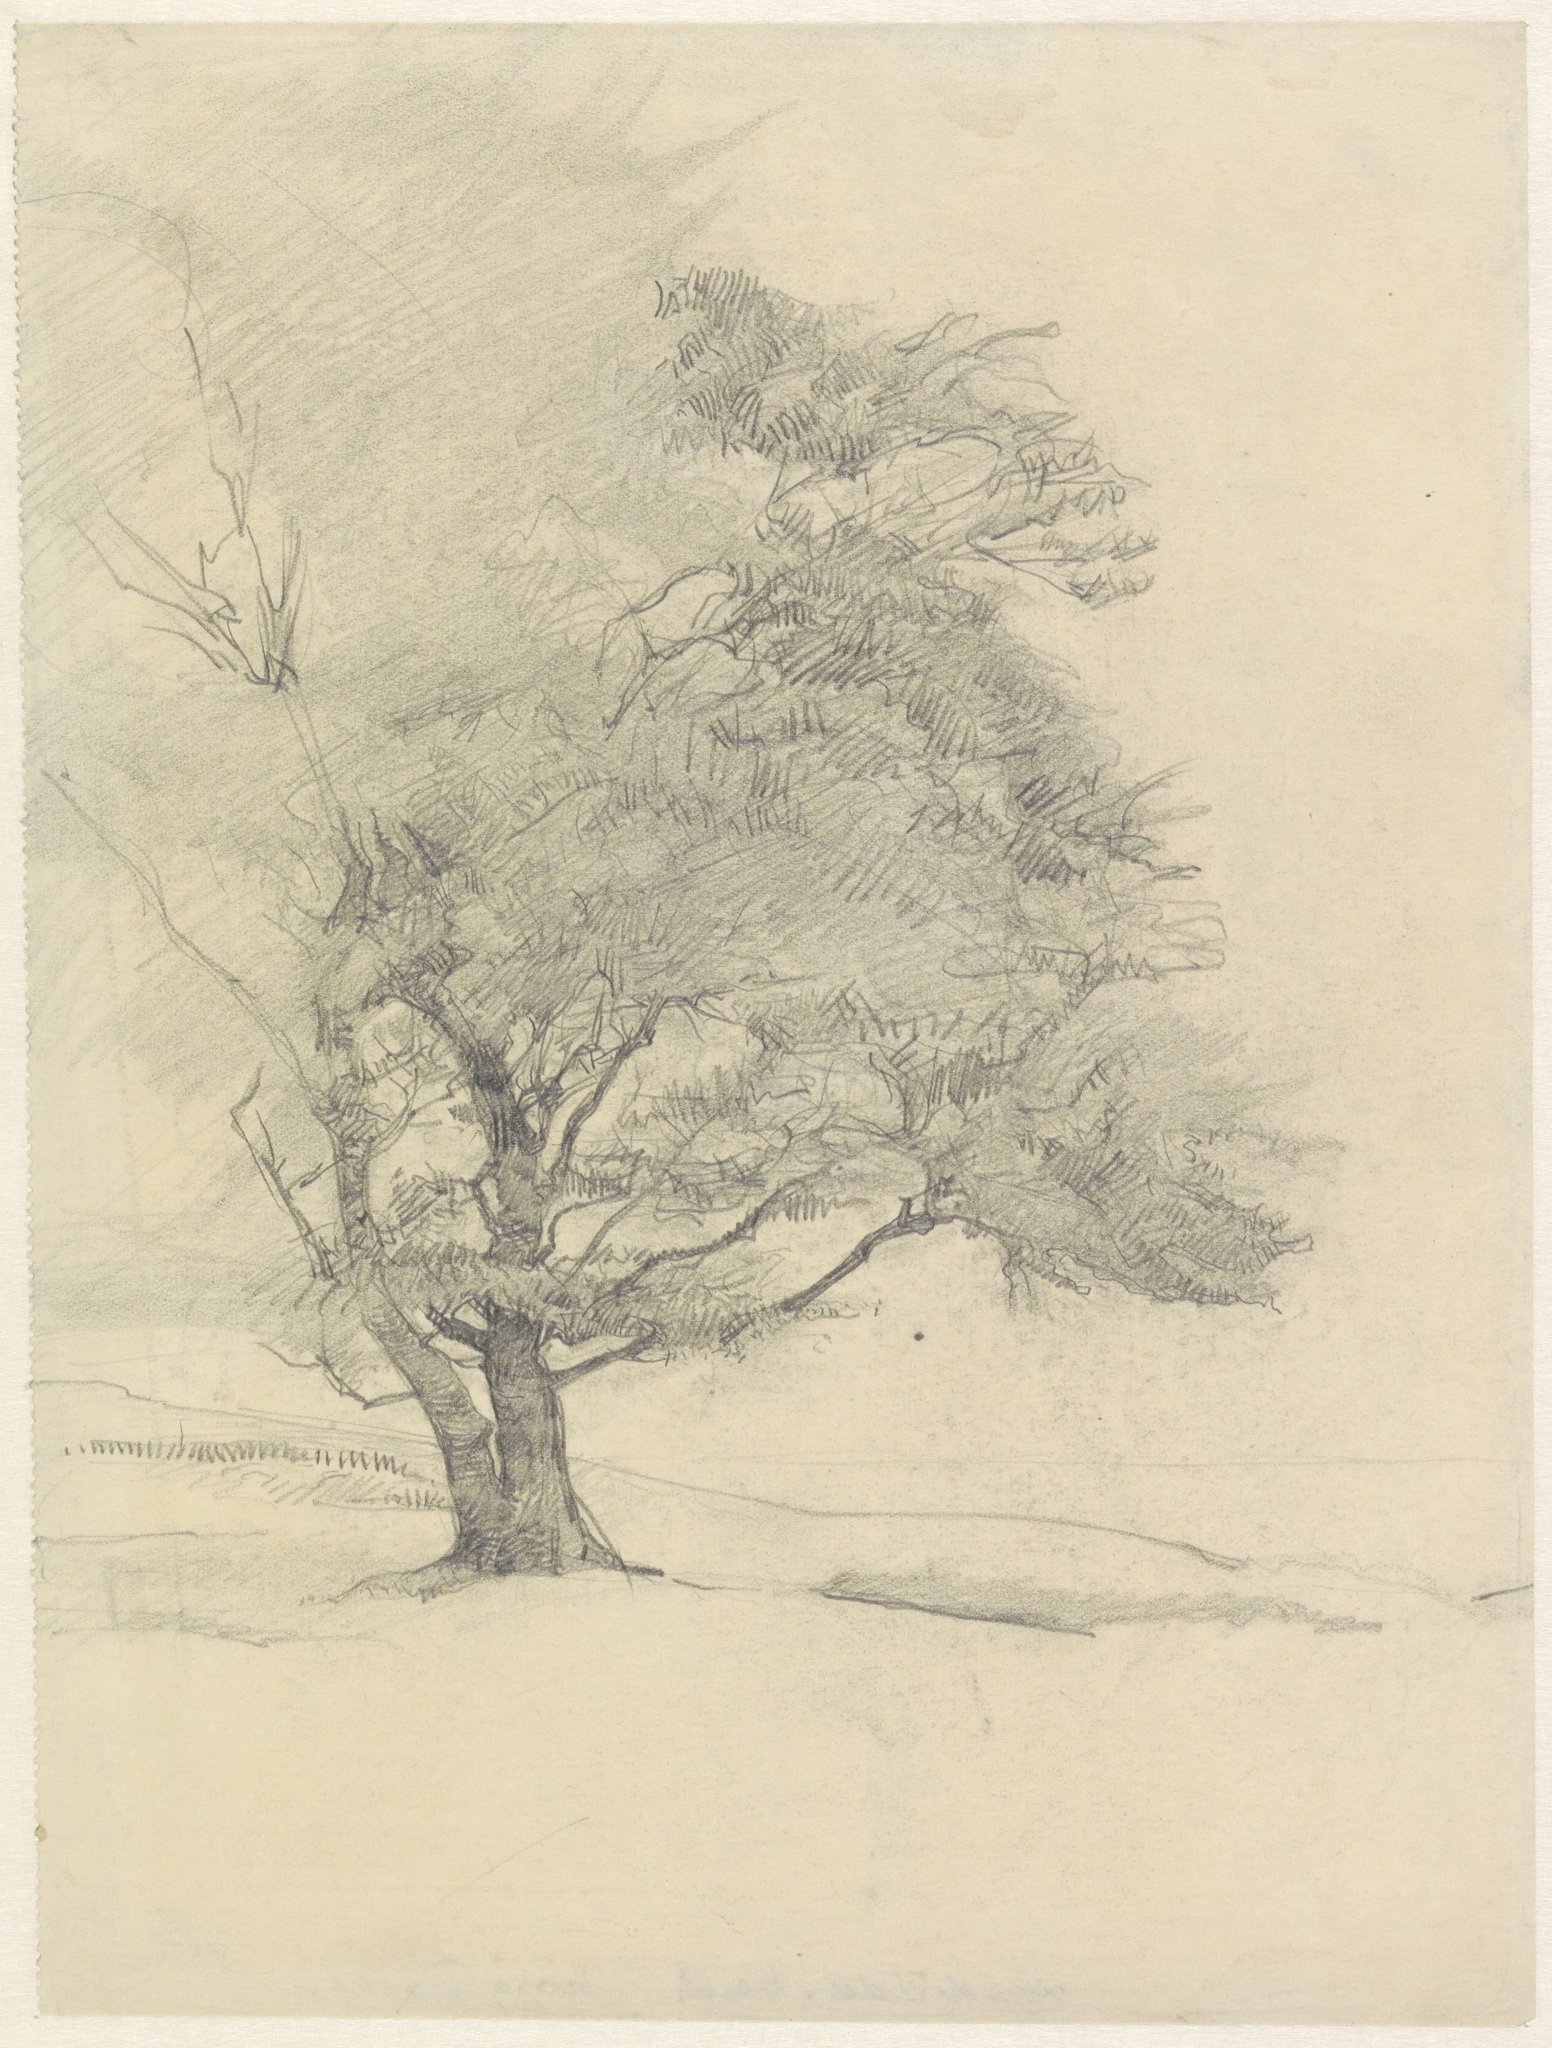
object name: drawing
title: De Schildersbeuk te Hoog-Soeren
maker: jan veth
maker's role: designer, draughtsman, painter, print maker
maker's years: 1864-1925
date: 1874-1925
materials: paper, pencil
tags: trees: beech